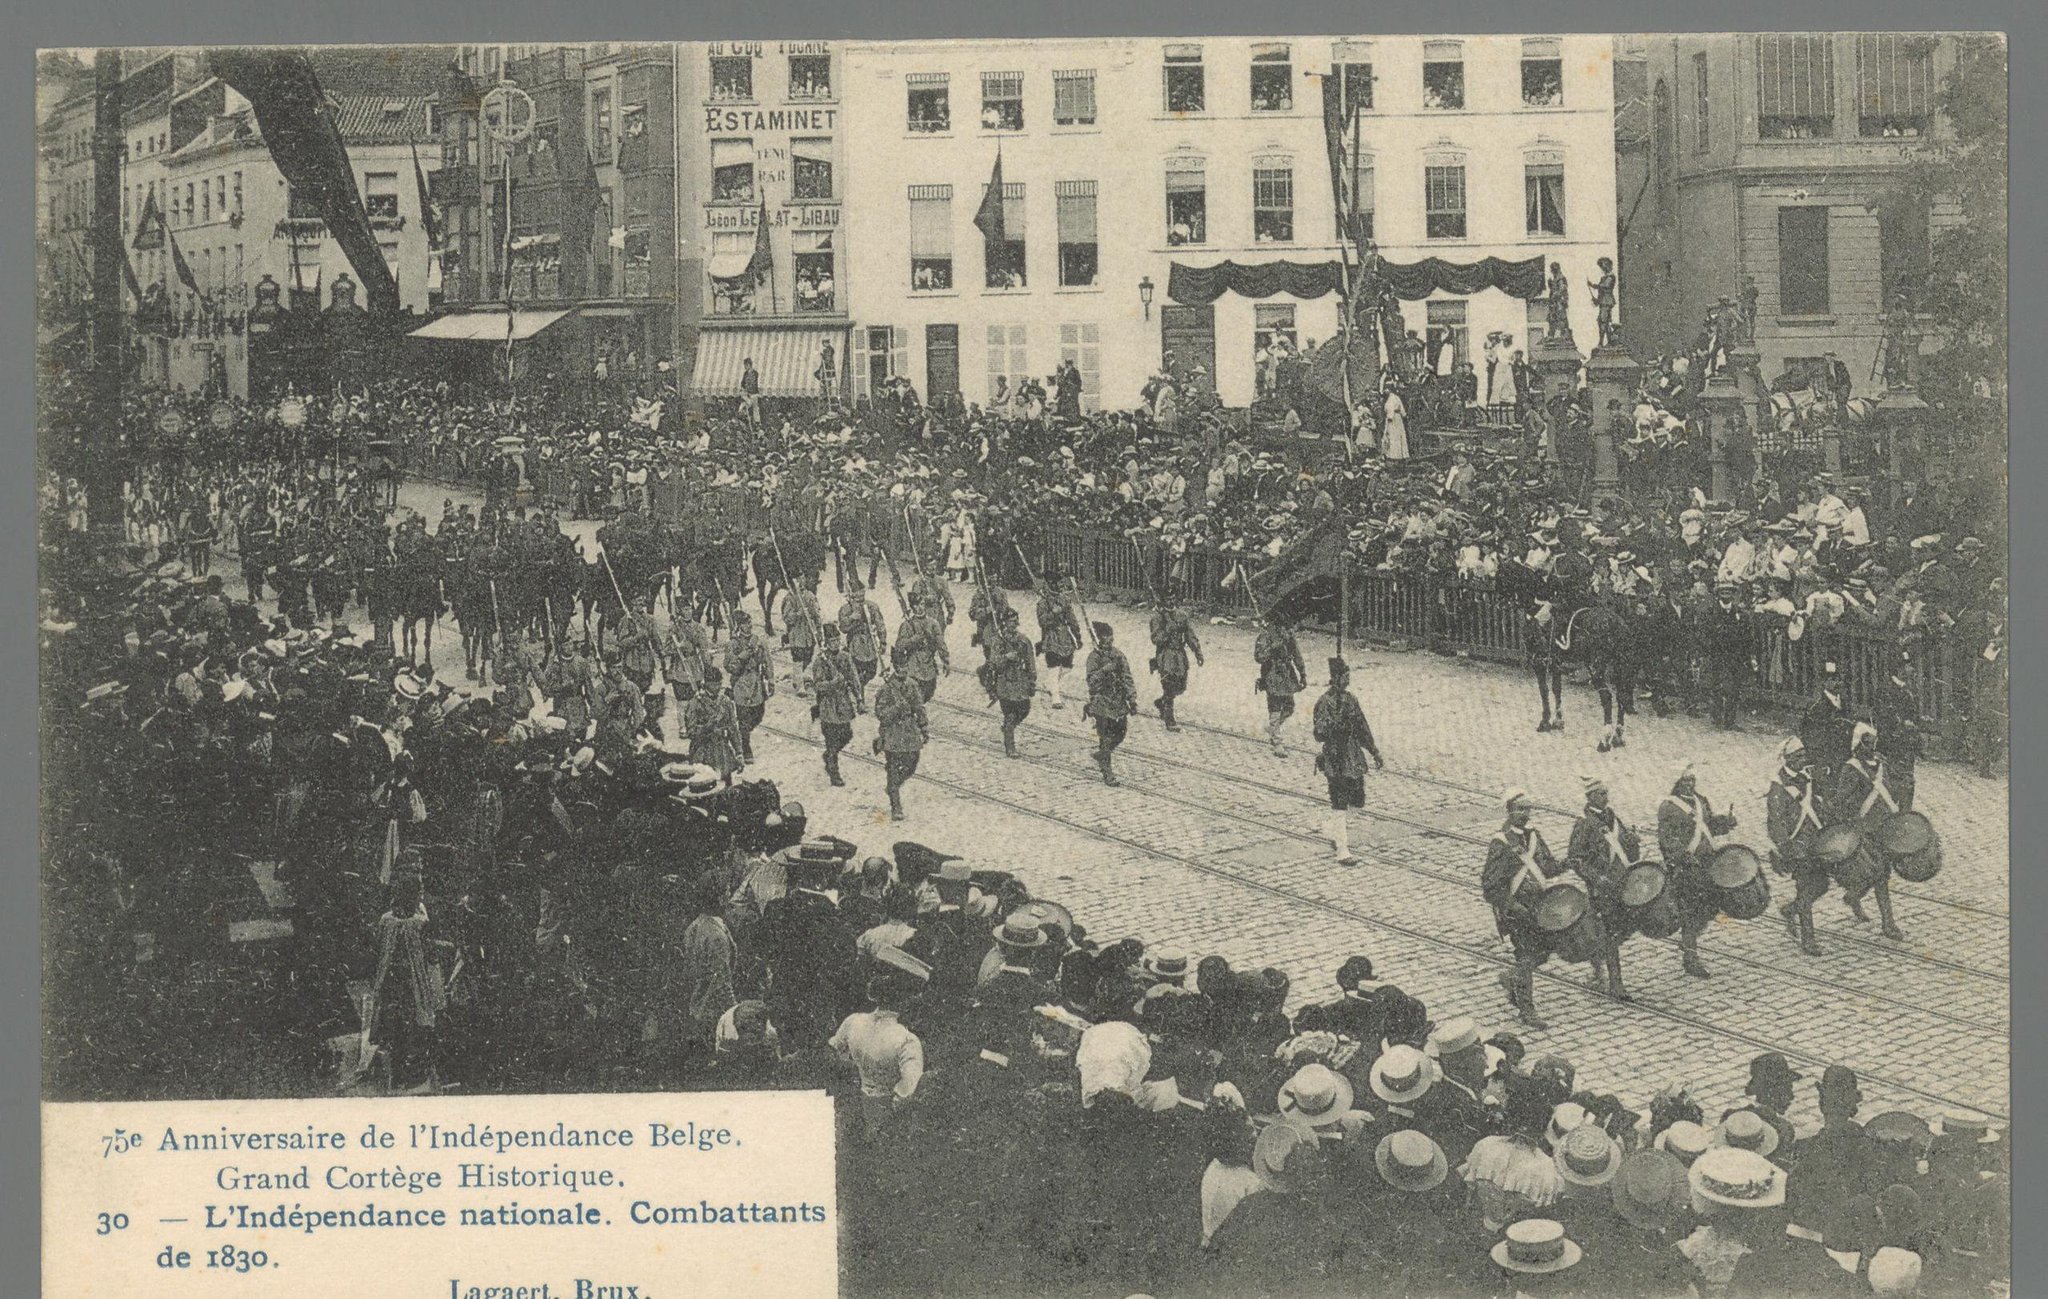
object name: photomechanical print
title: L'Indépendance nationale. Combattants de 1830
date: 1905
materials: cardboard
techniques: photograph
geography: schaarbeek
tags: city-view, and landscape with man-made constructions (+ city(-scape) with figures, staffage), periodic celebrations, popular feasts, brussels